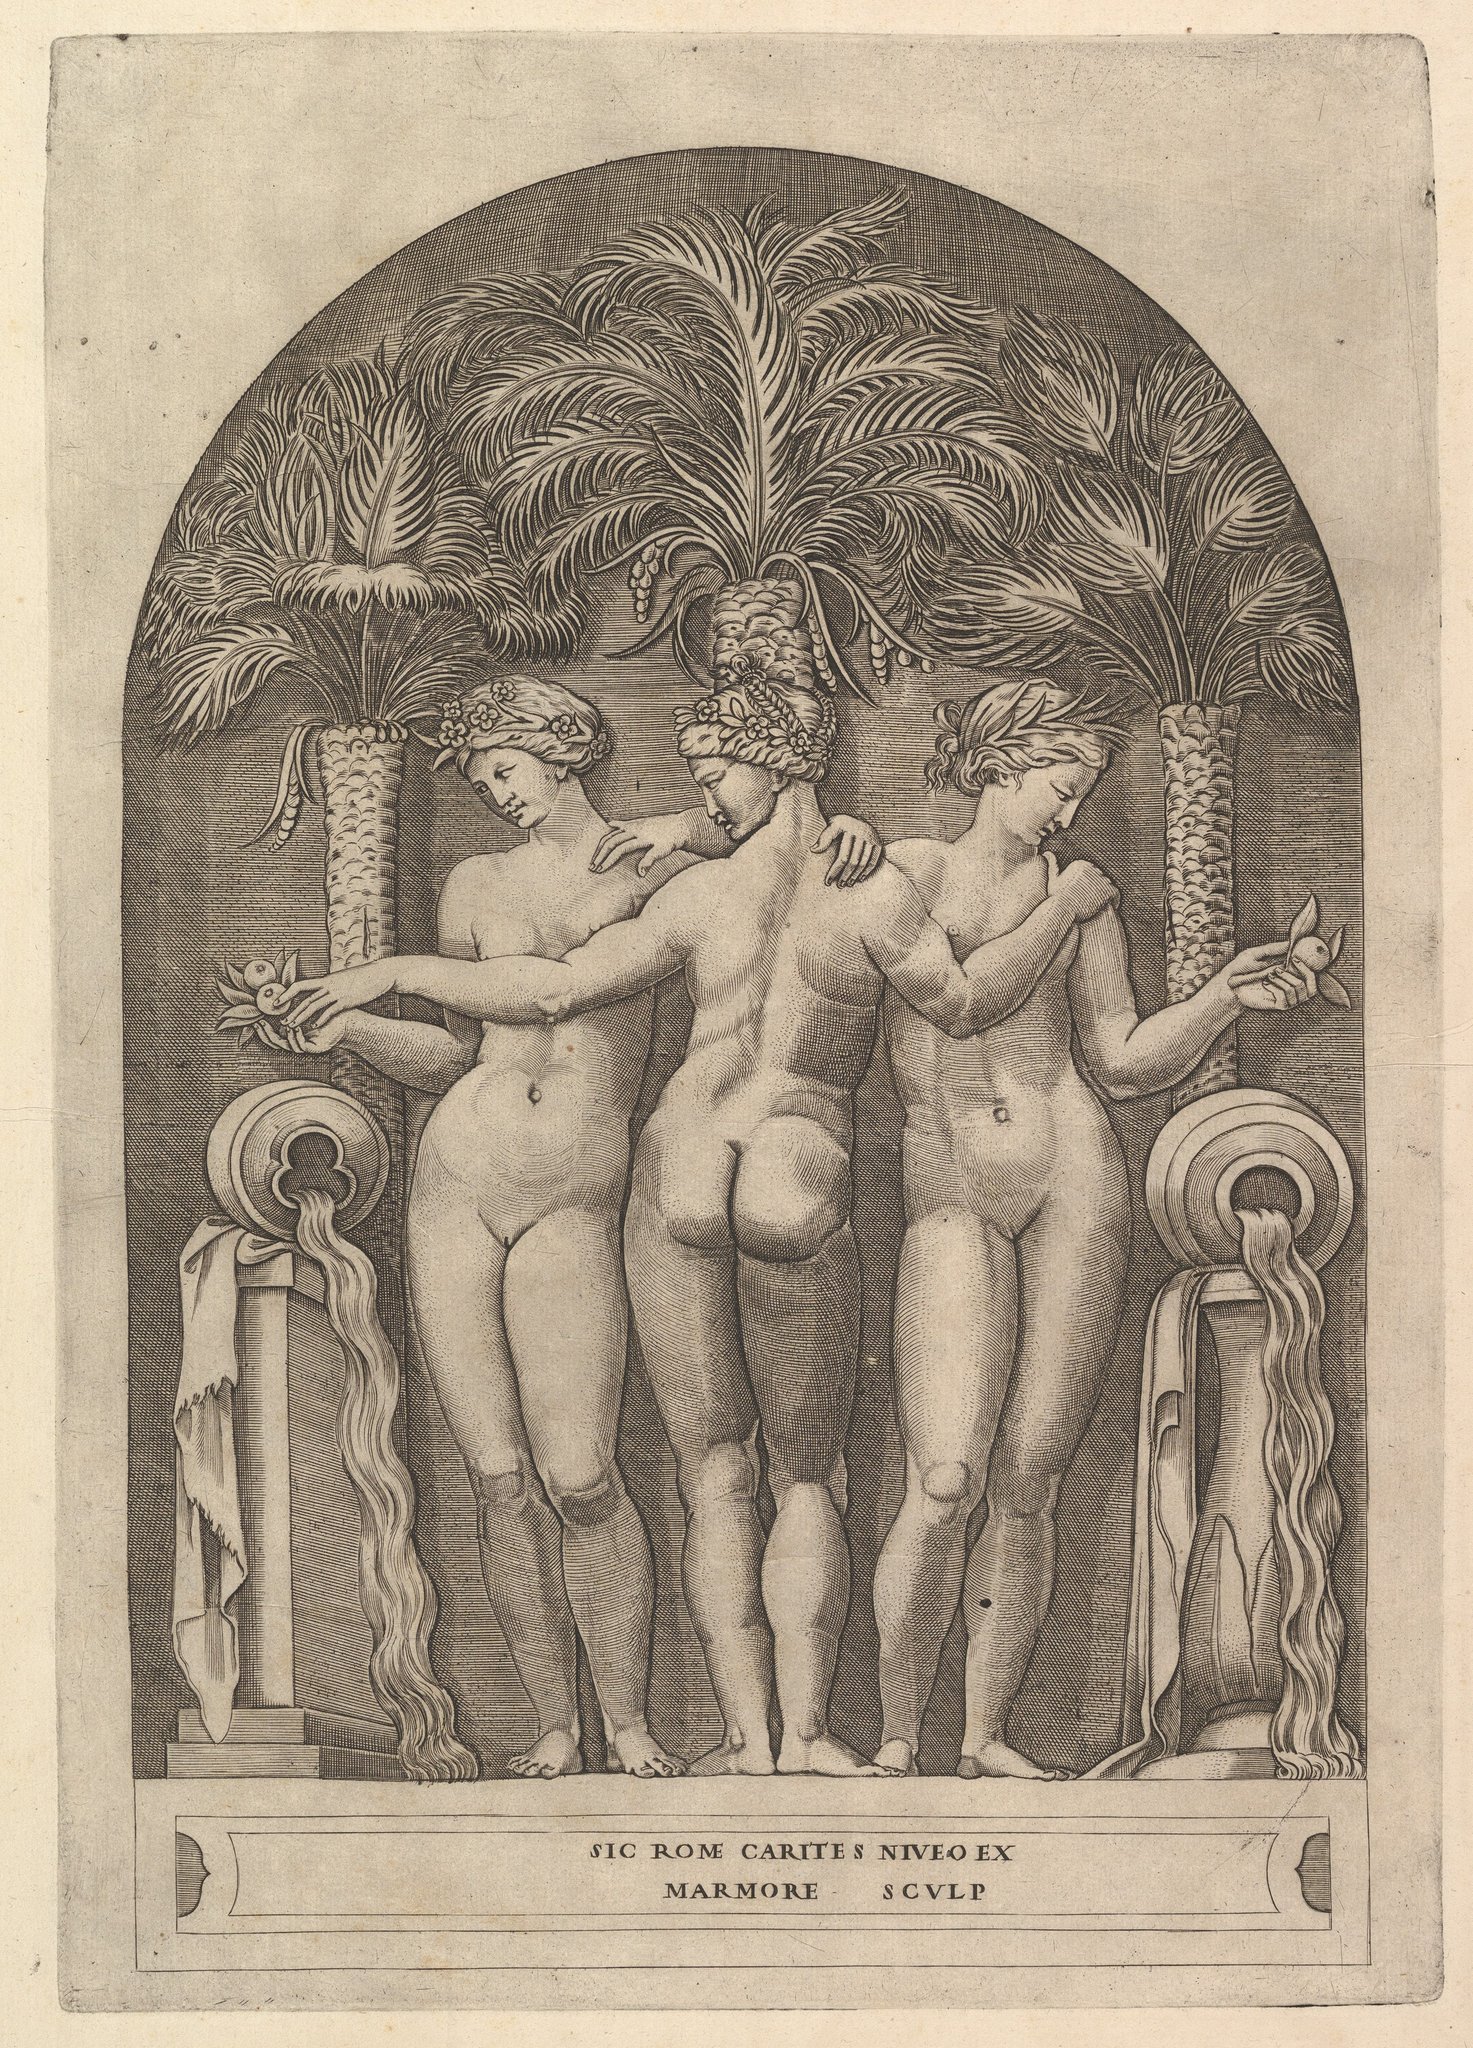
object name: print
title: The Three Graces, from "Speculum Romanae Magnificentiae"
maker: marco dente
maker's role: artist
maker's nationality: italian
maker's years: 1515-1527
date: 1515-1527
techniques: engraving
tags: female nudes,trees